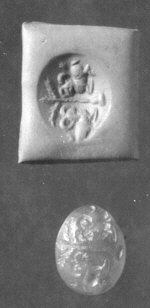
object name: stamp seal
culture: sasanian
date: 201-700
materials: gemstone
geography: iran or mesopotamia